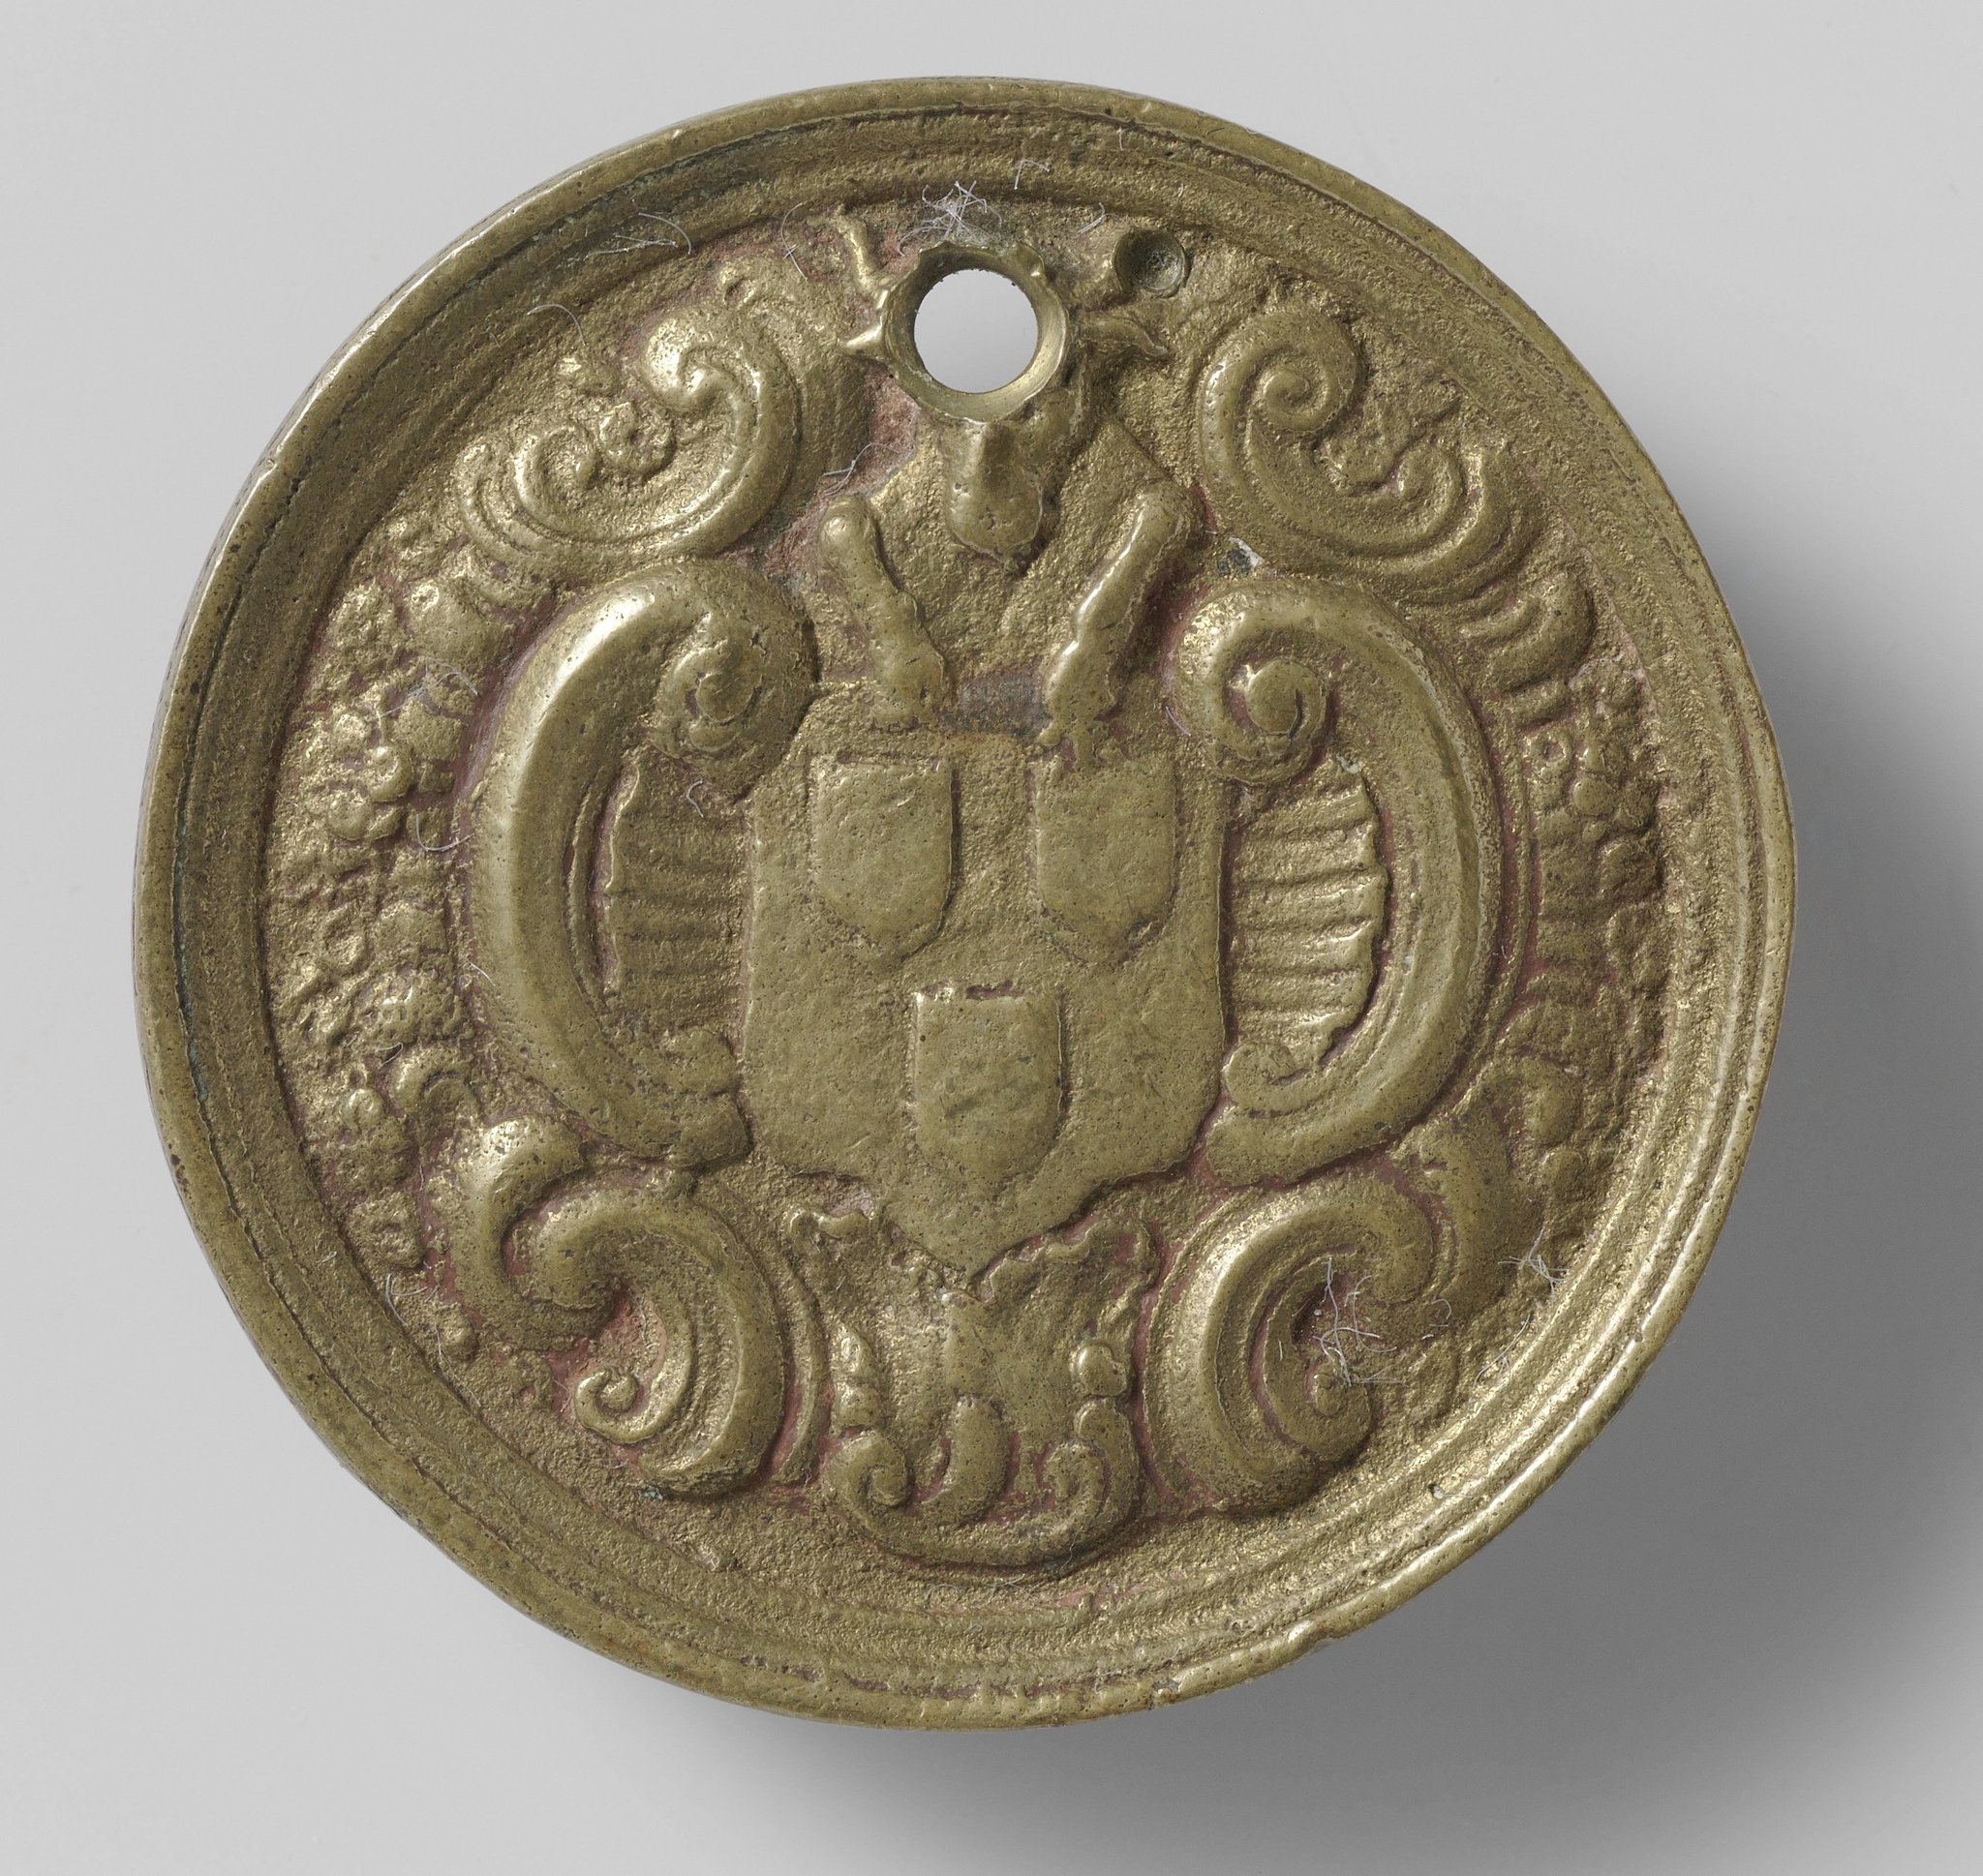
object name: medal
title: St. Lucasgilde van Amsterdam, gildepenning van Willem Uppink, schilder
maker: Anonymous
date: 1788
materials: brass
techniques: casting, engraving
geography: amsterdam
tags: amsterdam, painter, draughtsman, willem uppink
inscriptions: : ‘WILLEM UPPINK’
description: Willem Uppink (1767-1849) was een Amsterdamse behangselschilder. In het Honig Breethuis in Zaandijk is een van zijn panoramische ensembles nog aanwezig; nog vier andere ensembles zijn elders bewaard gebleven, maar niet publiek toegankelijk. Het Rijksmuseum bezit onder meer een (vermoedelijk) zelfportret uit hetzelfde jaar als de penning (inv.nr. SK-A-3055).